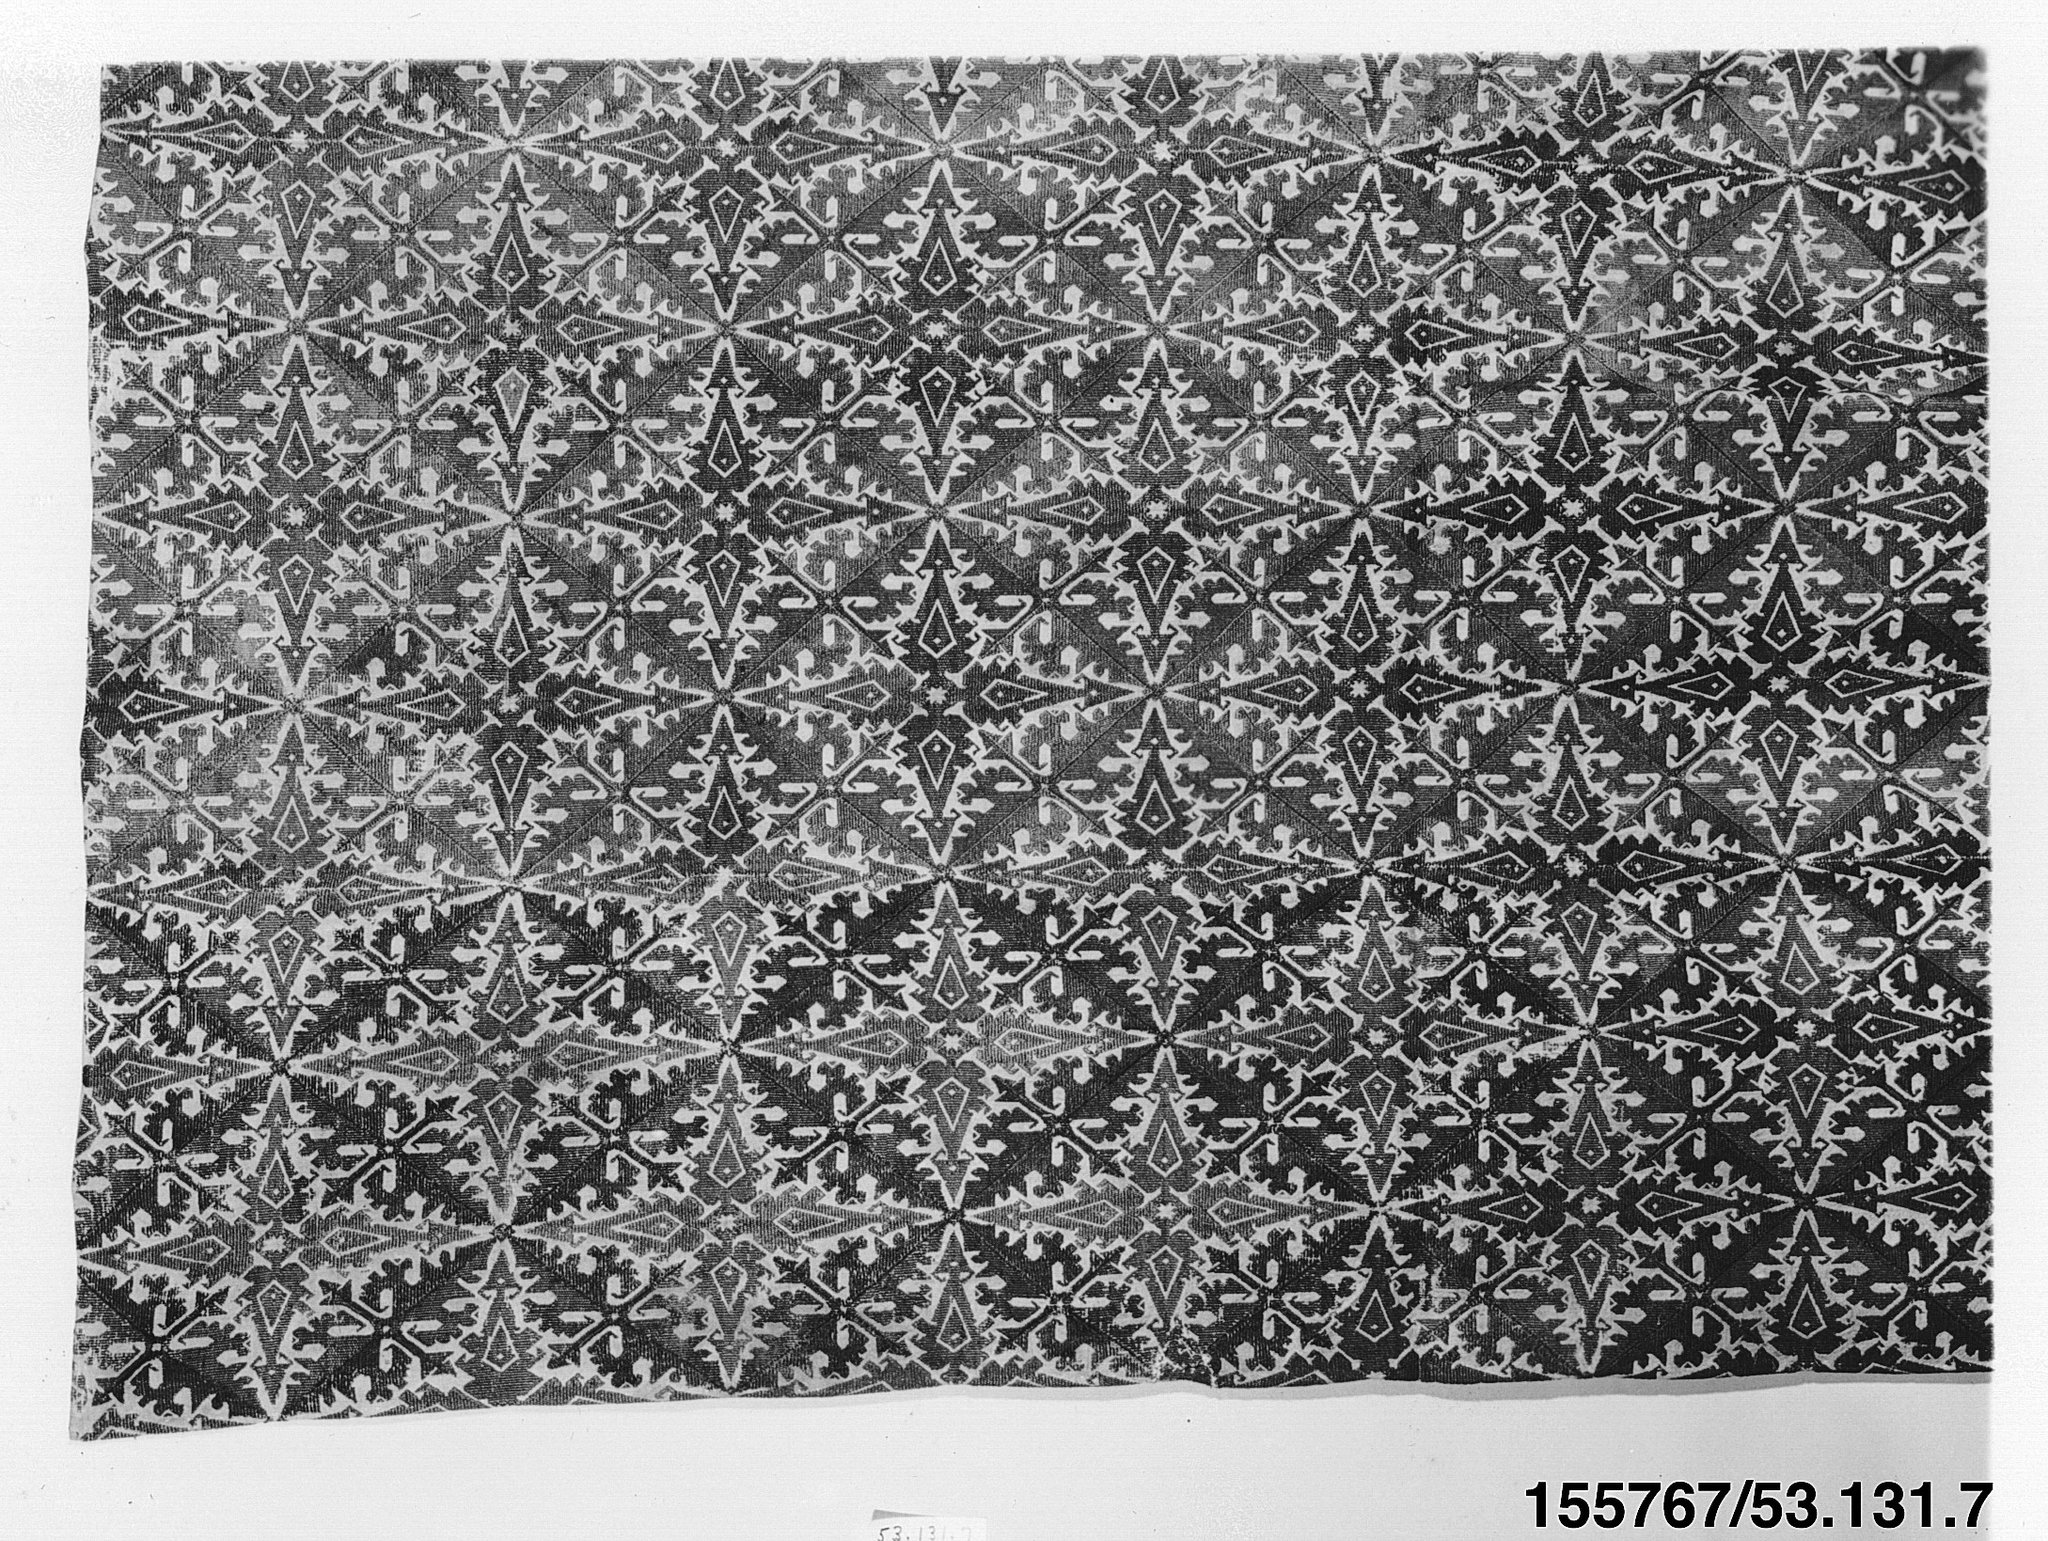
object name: bed curtain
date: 1601-1800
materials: linen, silk